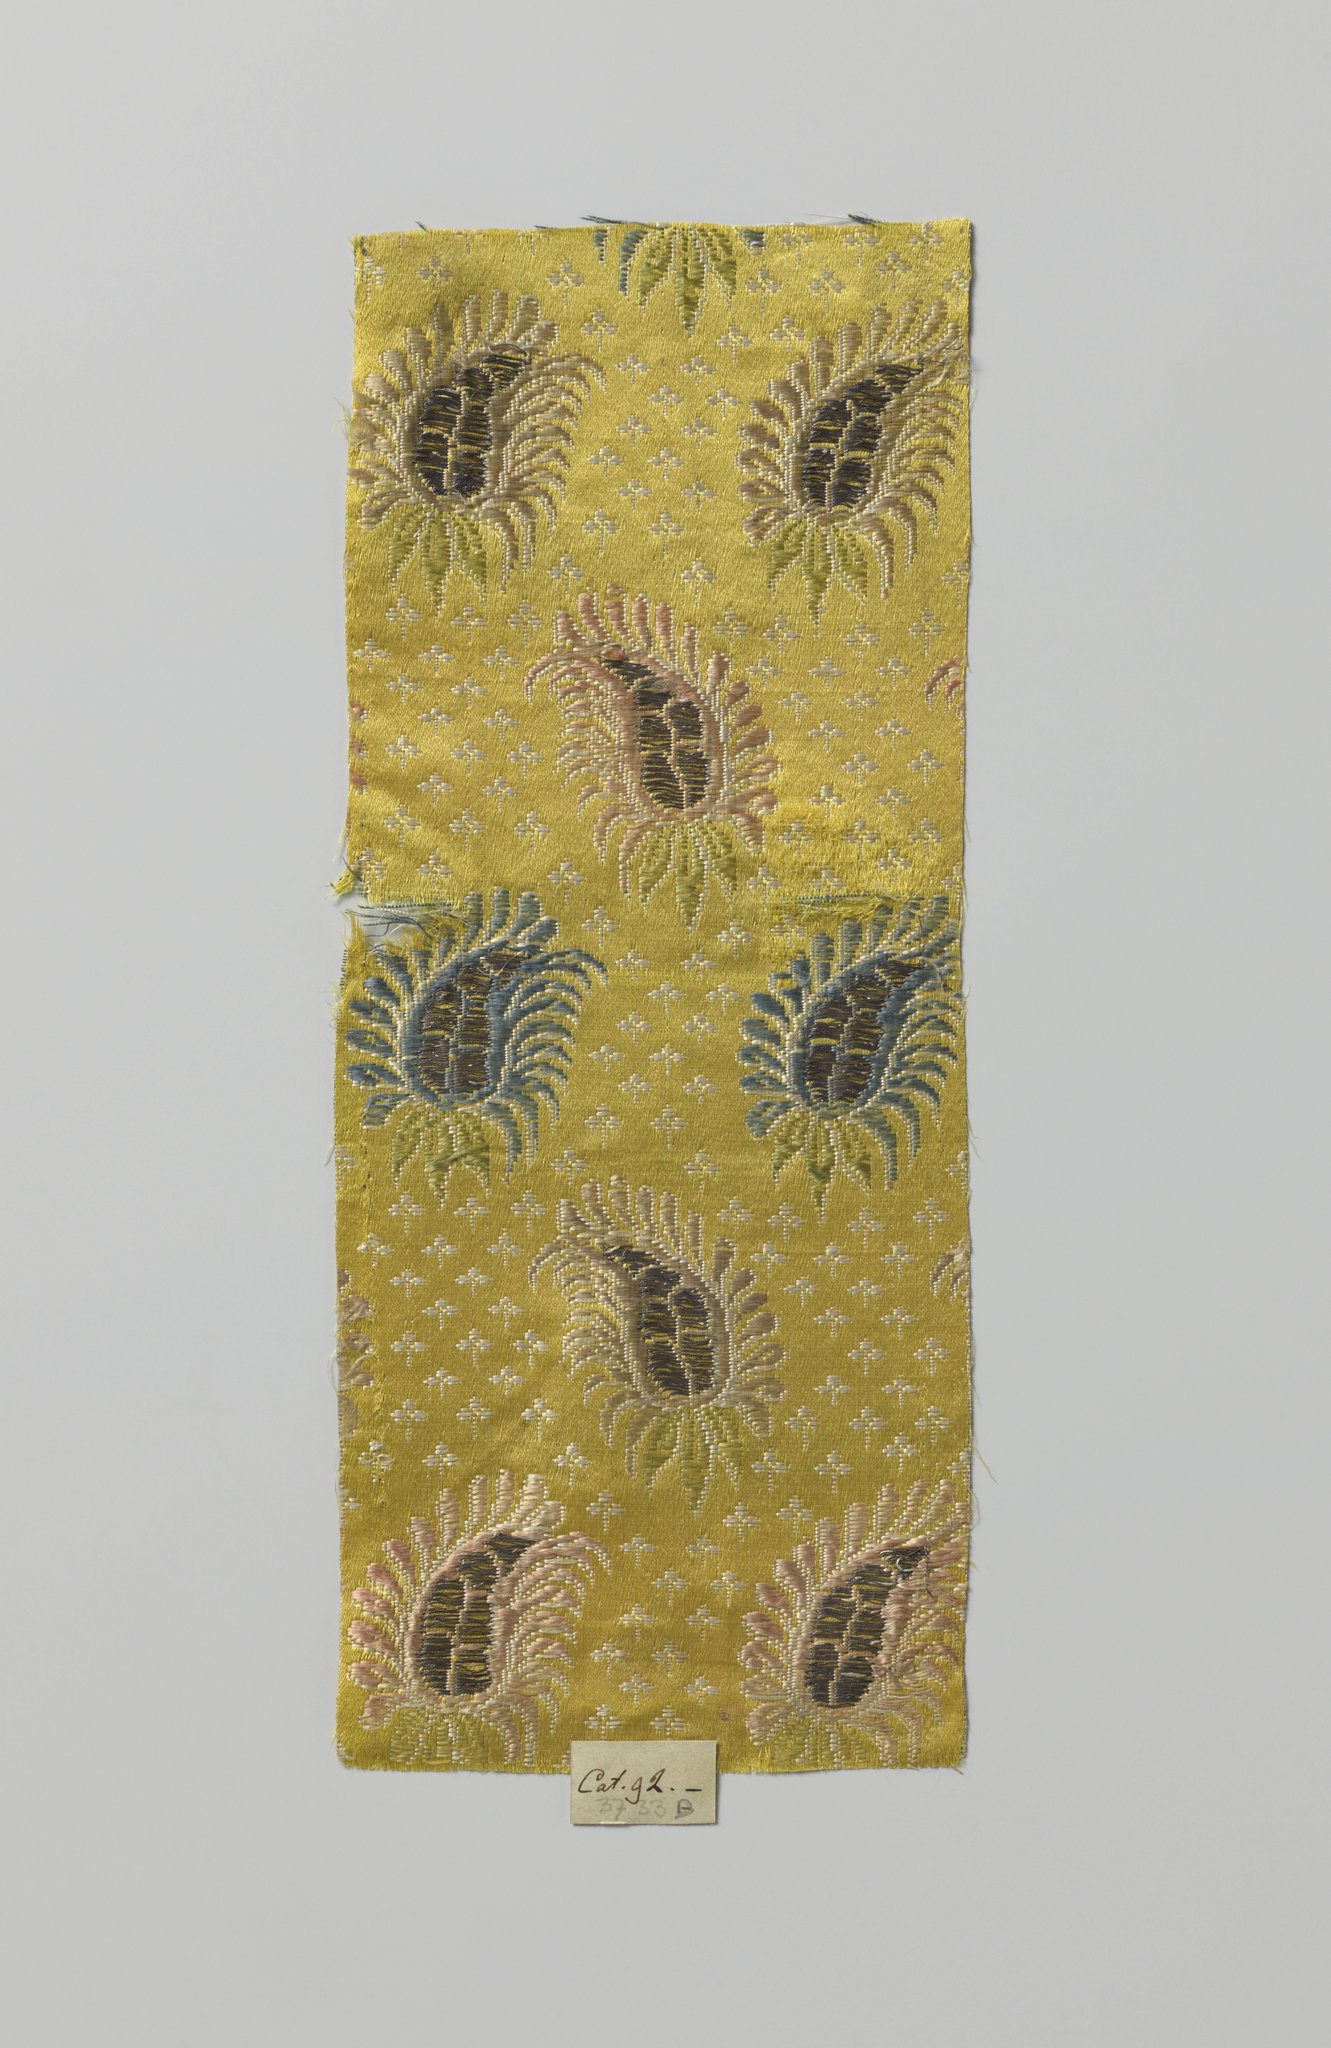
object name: fragment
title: Fragment veelkleurig zijdelampas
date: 1650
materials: silk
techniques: lampas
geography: spain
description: Een fragment van geel zijdeweefsel met witte klaverblaadjes en verder palmen van verschillend gekleurde zijde.